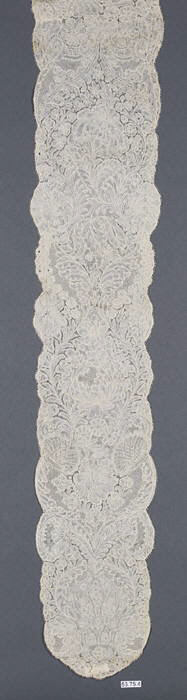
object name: lappet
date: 1701-1750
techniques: lace